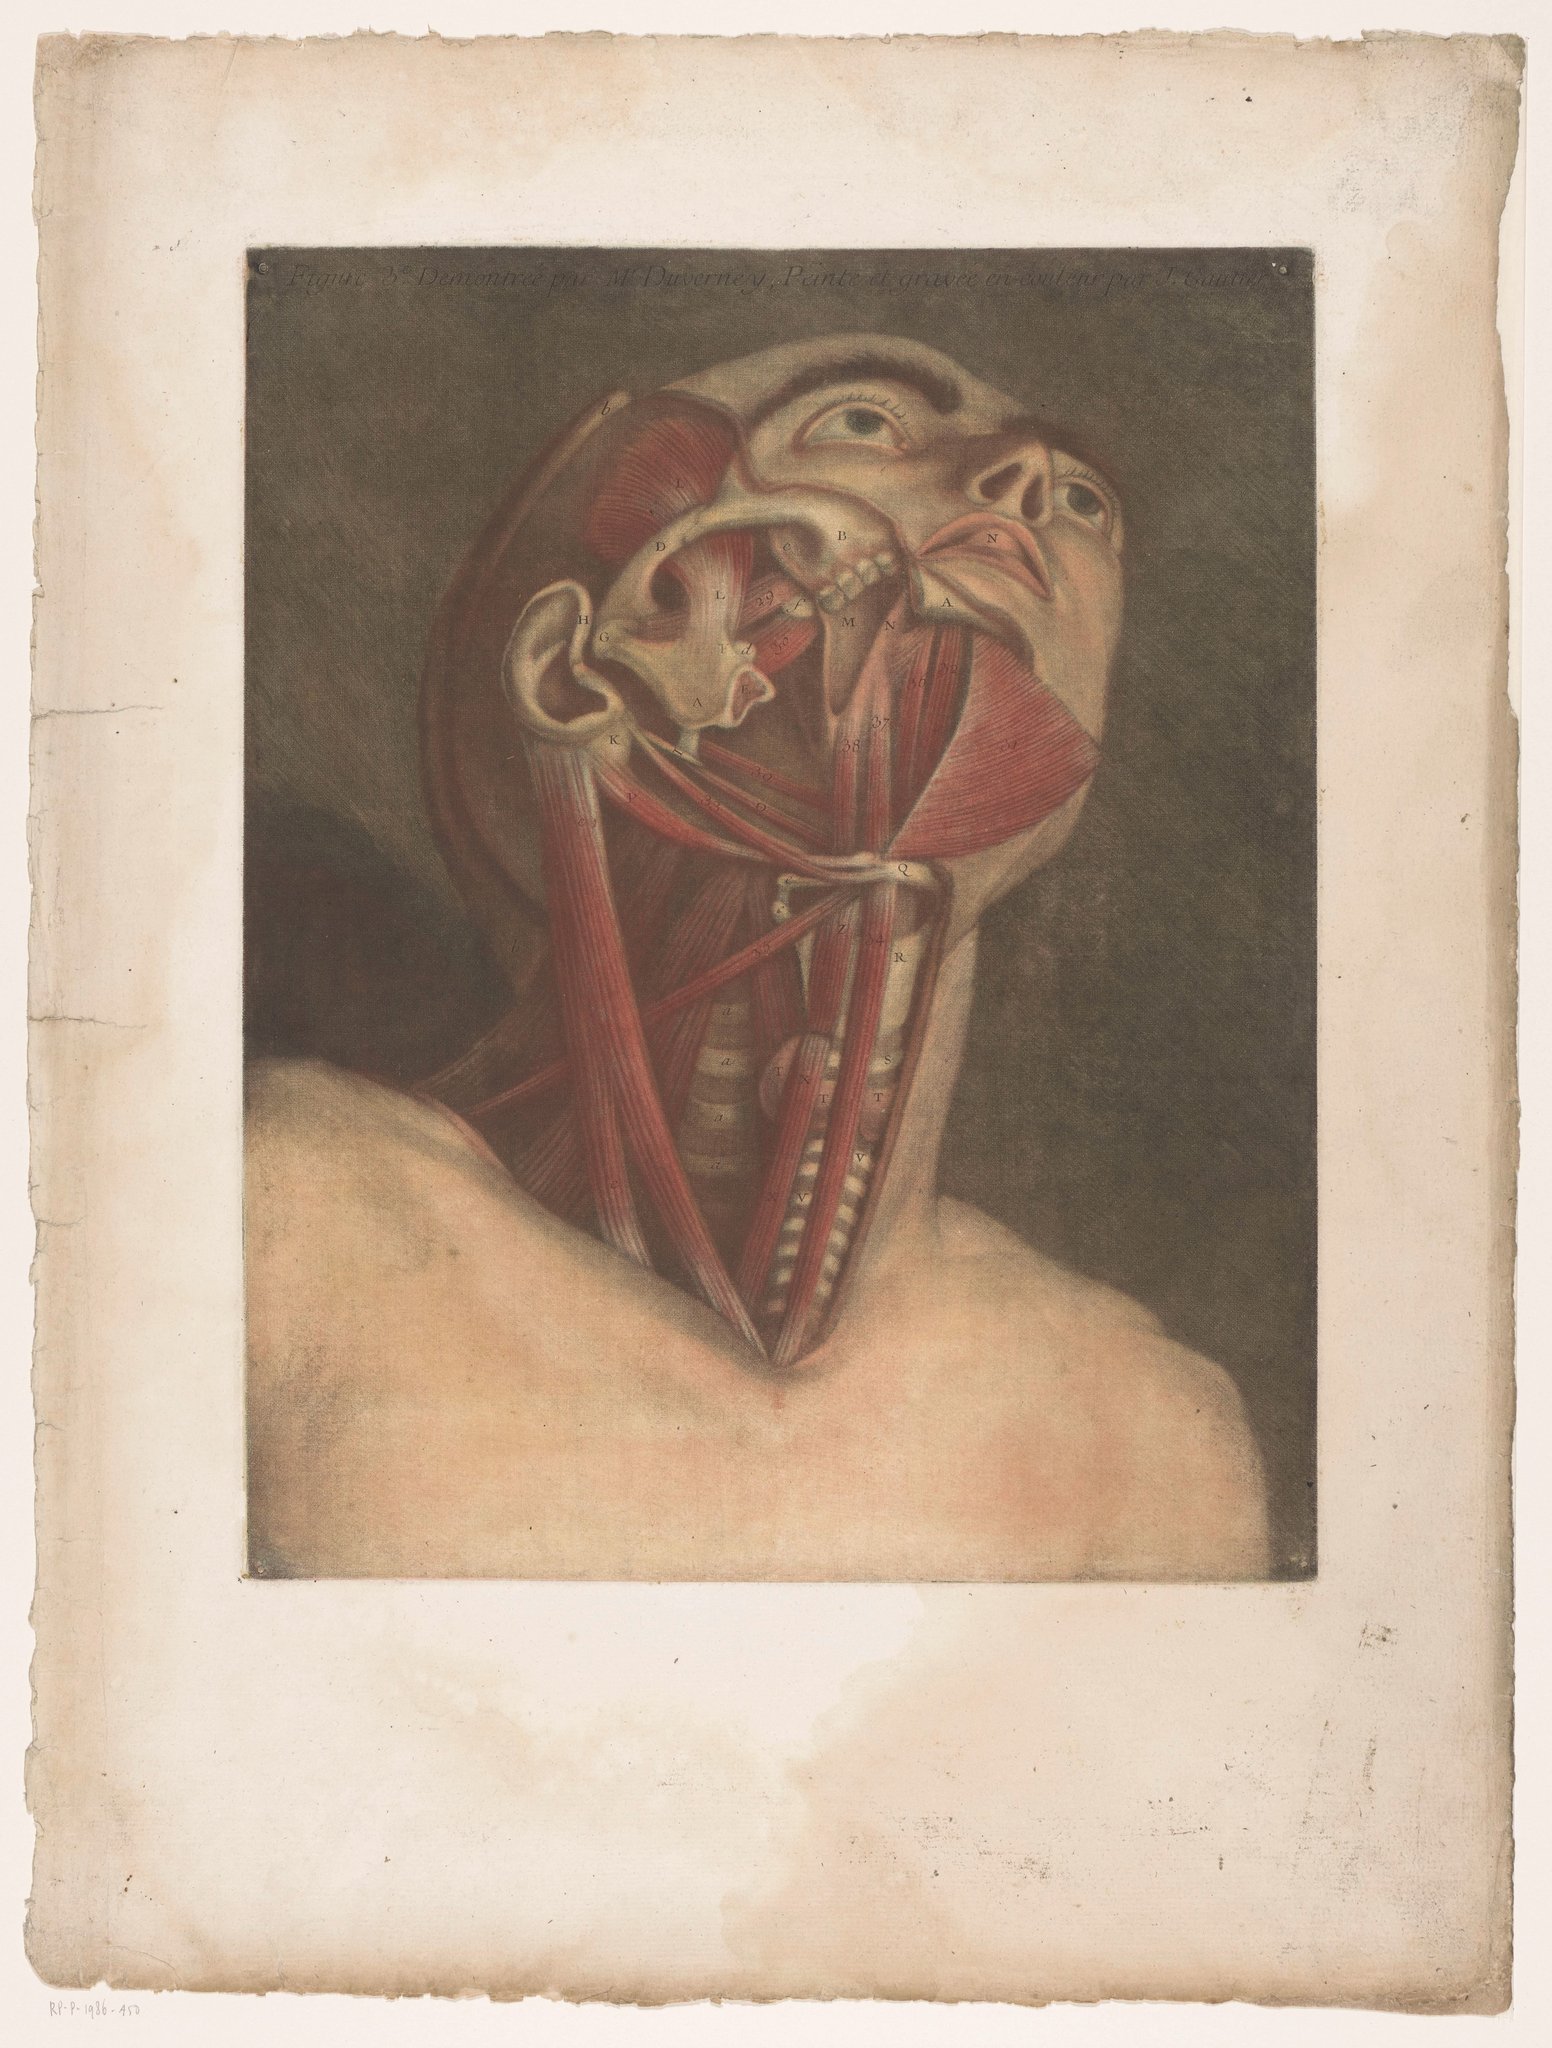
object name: print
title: Myologie complette en couleur et grandeur naturelle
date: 1745-1746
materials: paper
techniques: engraving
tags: anatomical model of the muscles, muscle-man, 'écorché'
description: Prent gebruikt in: Gautier d'Agoty, Jacques Fabien. Essai d'Anatomie, en tableaux imprimés, qui representent au naturel tous les muscles (...) disséquées & préparées par Monsieur Duverney (...). Parijs: Jacques Fabien Gautier d'Agoty, 1745, plaat 3. En in: Gautier d'Agoty, Jacques Fabien. Myologie complette en couleur et grandeur naturelle (...). Parijs: Jacques Fabien Gautier d'Agoty e.a., 1746, plaat 3.